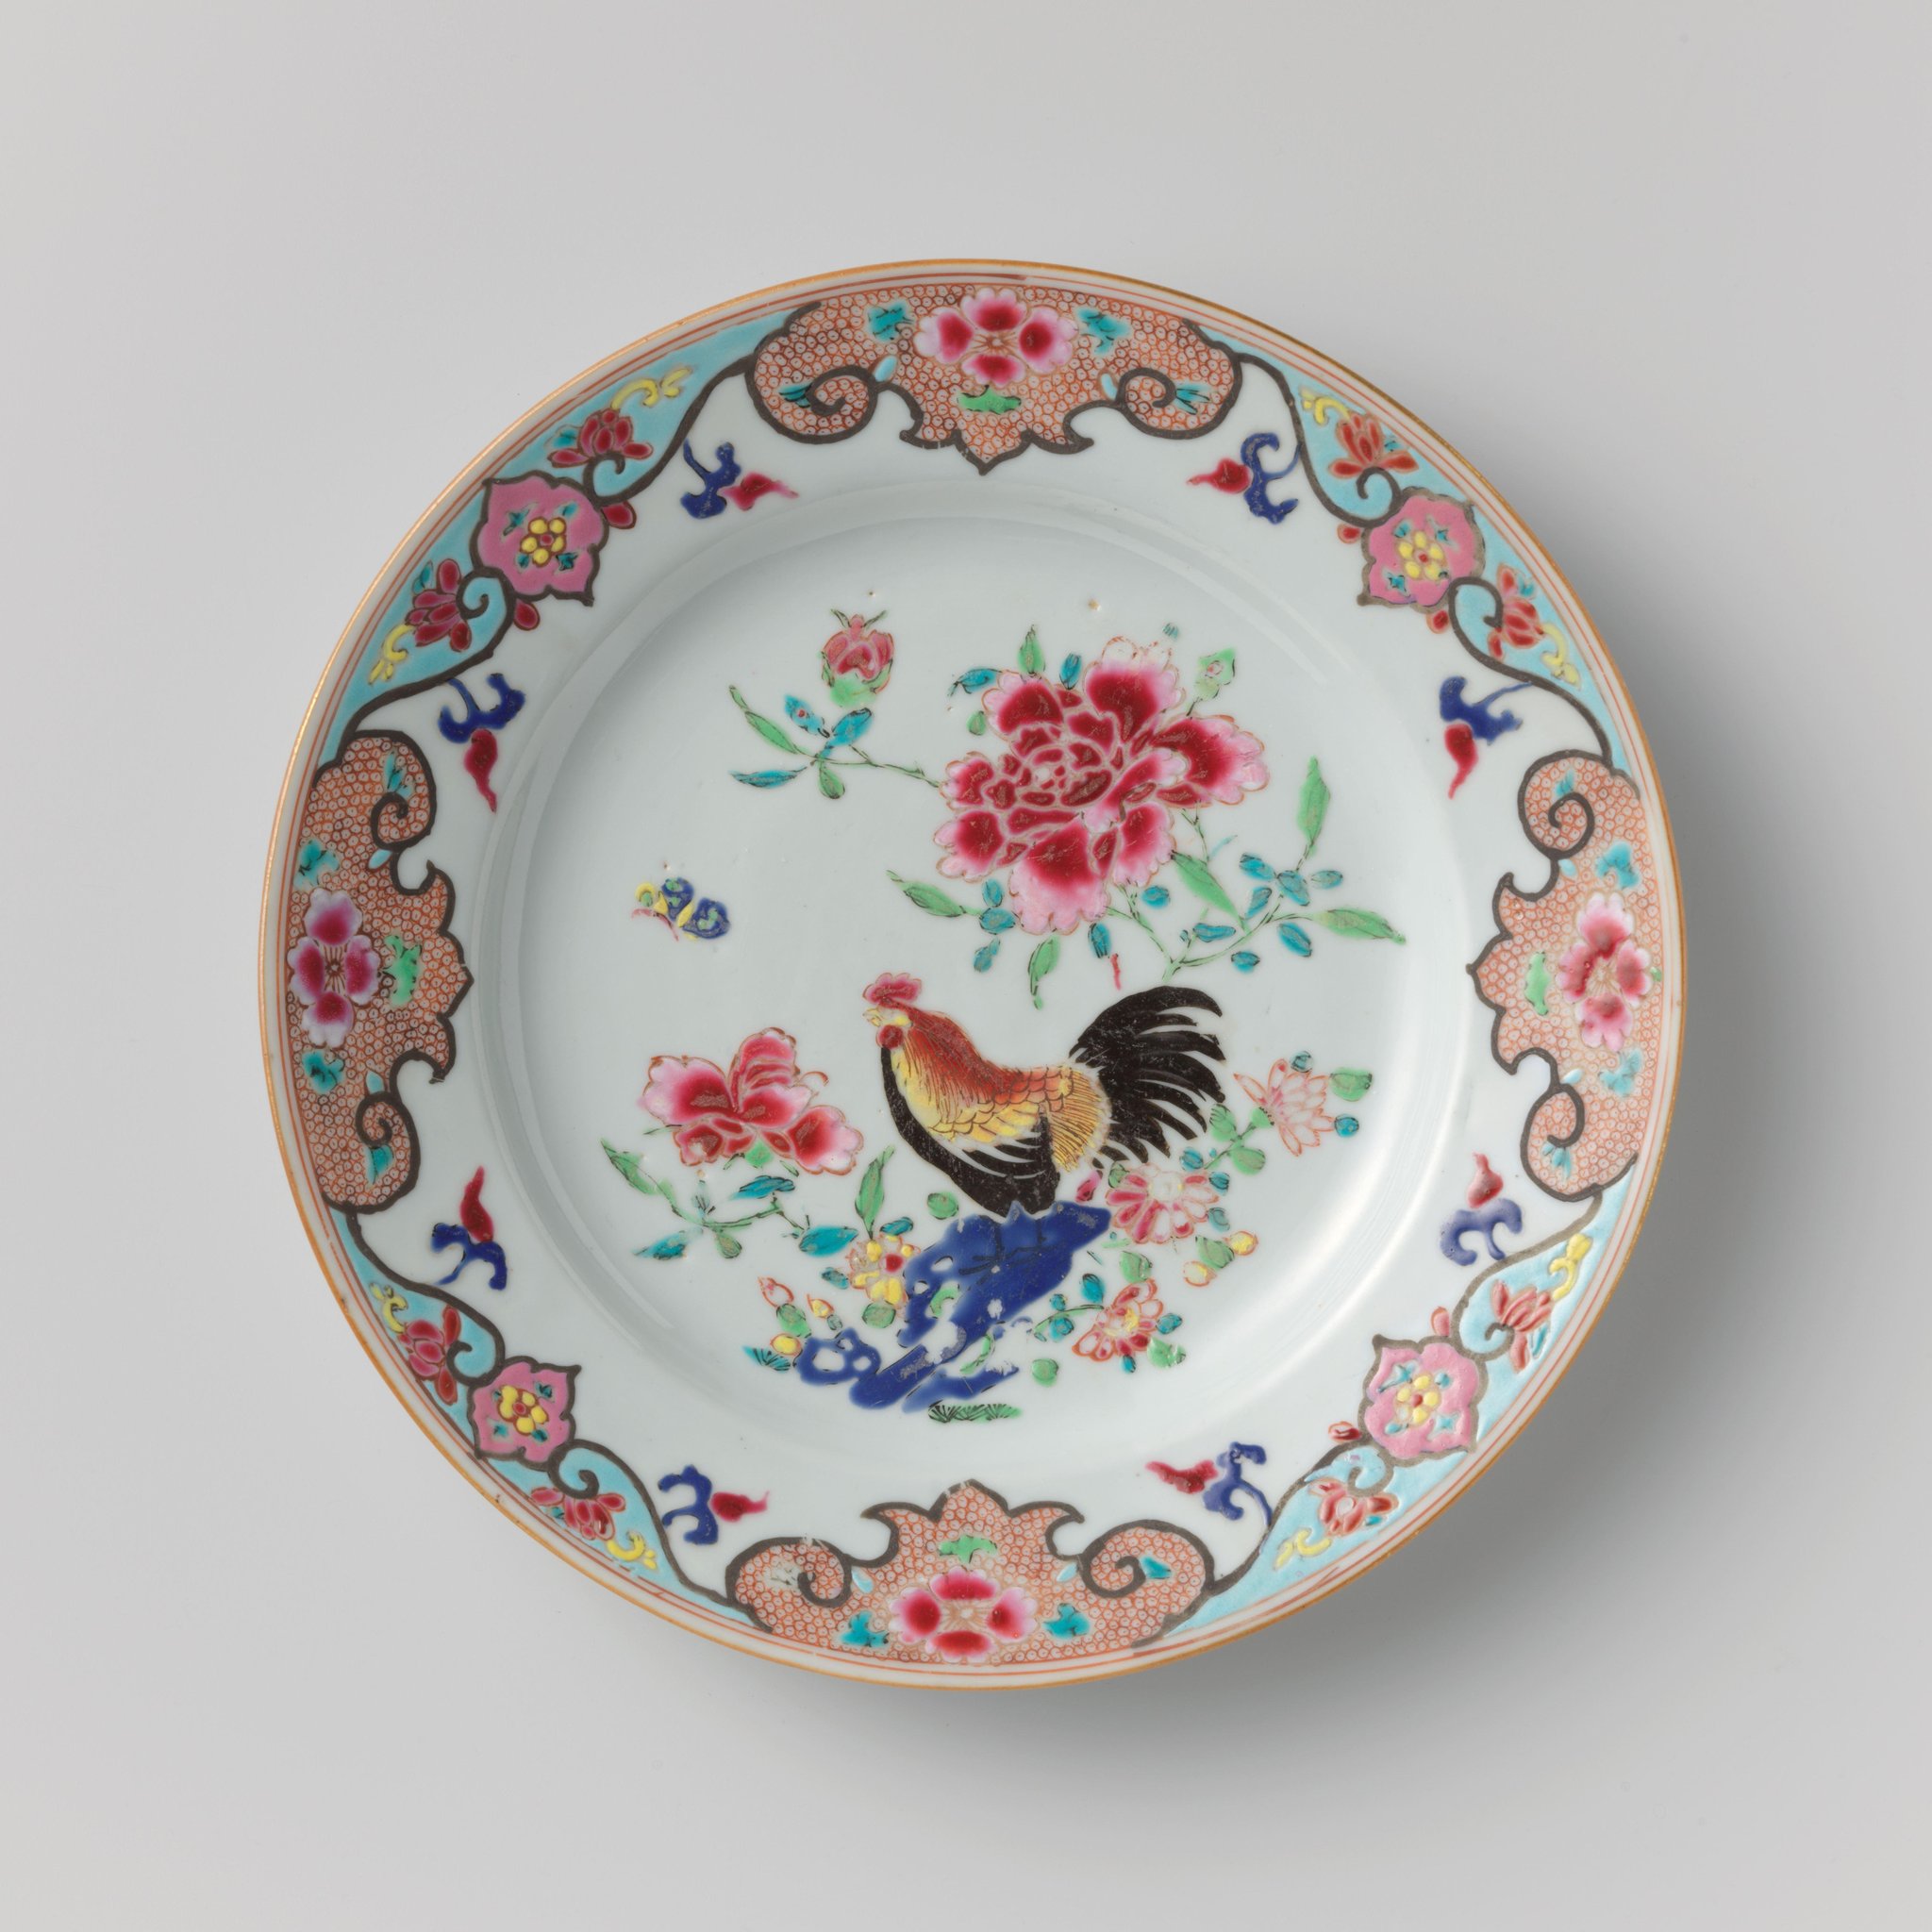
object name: plate dish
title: Plate with a cock on a rock near flowering plants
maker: Anonymous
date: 1800-1899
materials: glaze, paint, porcelain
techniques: firing, turning, vitrification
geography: china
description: Bord van porselein, beschilderd op het glazuur in blauw, rood, roze, groen, geel en zwart. Op het plat een haan op een rots bij bloeiende planten (pioen, aster) en een vlinder; op de rand een decoratieve band met krulwerk, servetwerk, bloemtakken en gestileerde lotusranken. Famille rose.